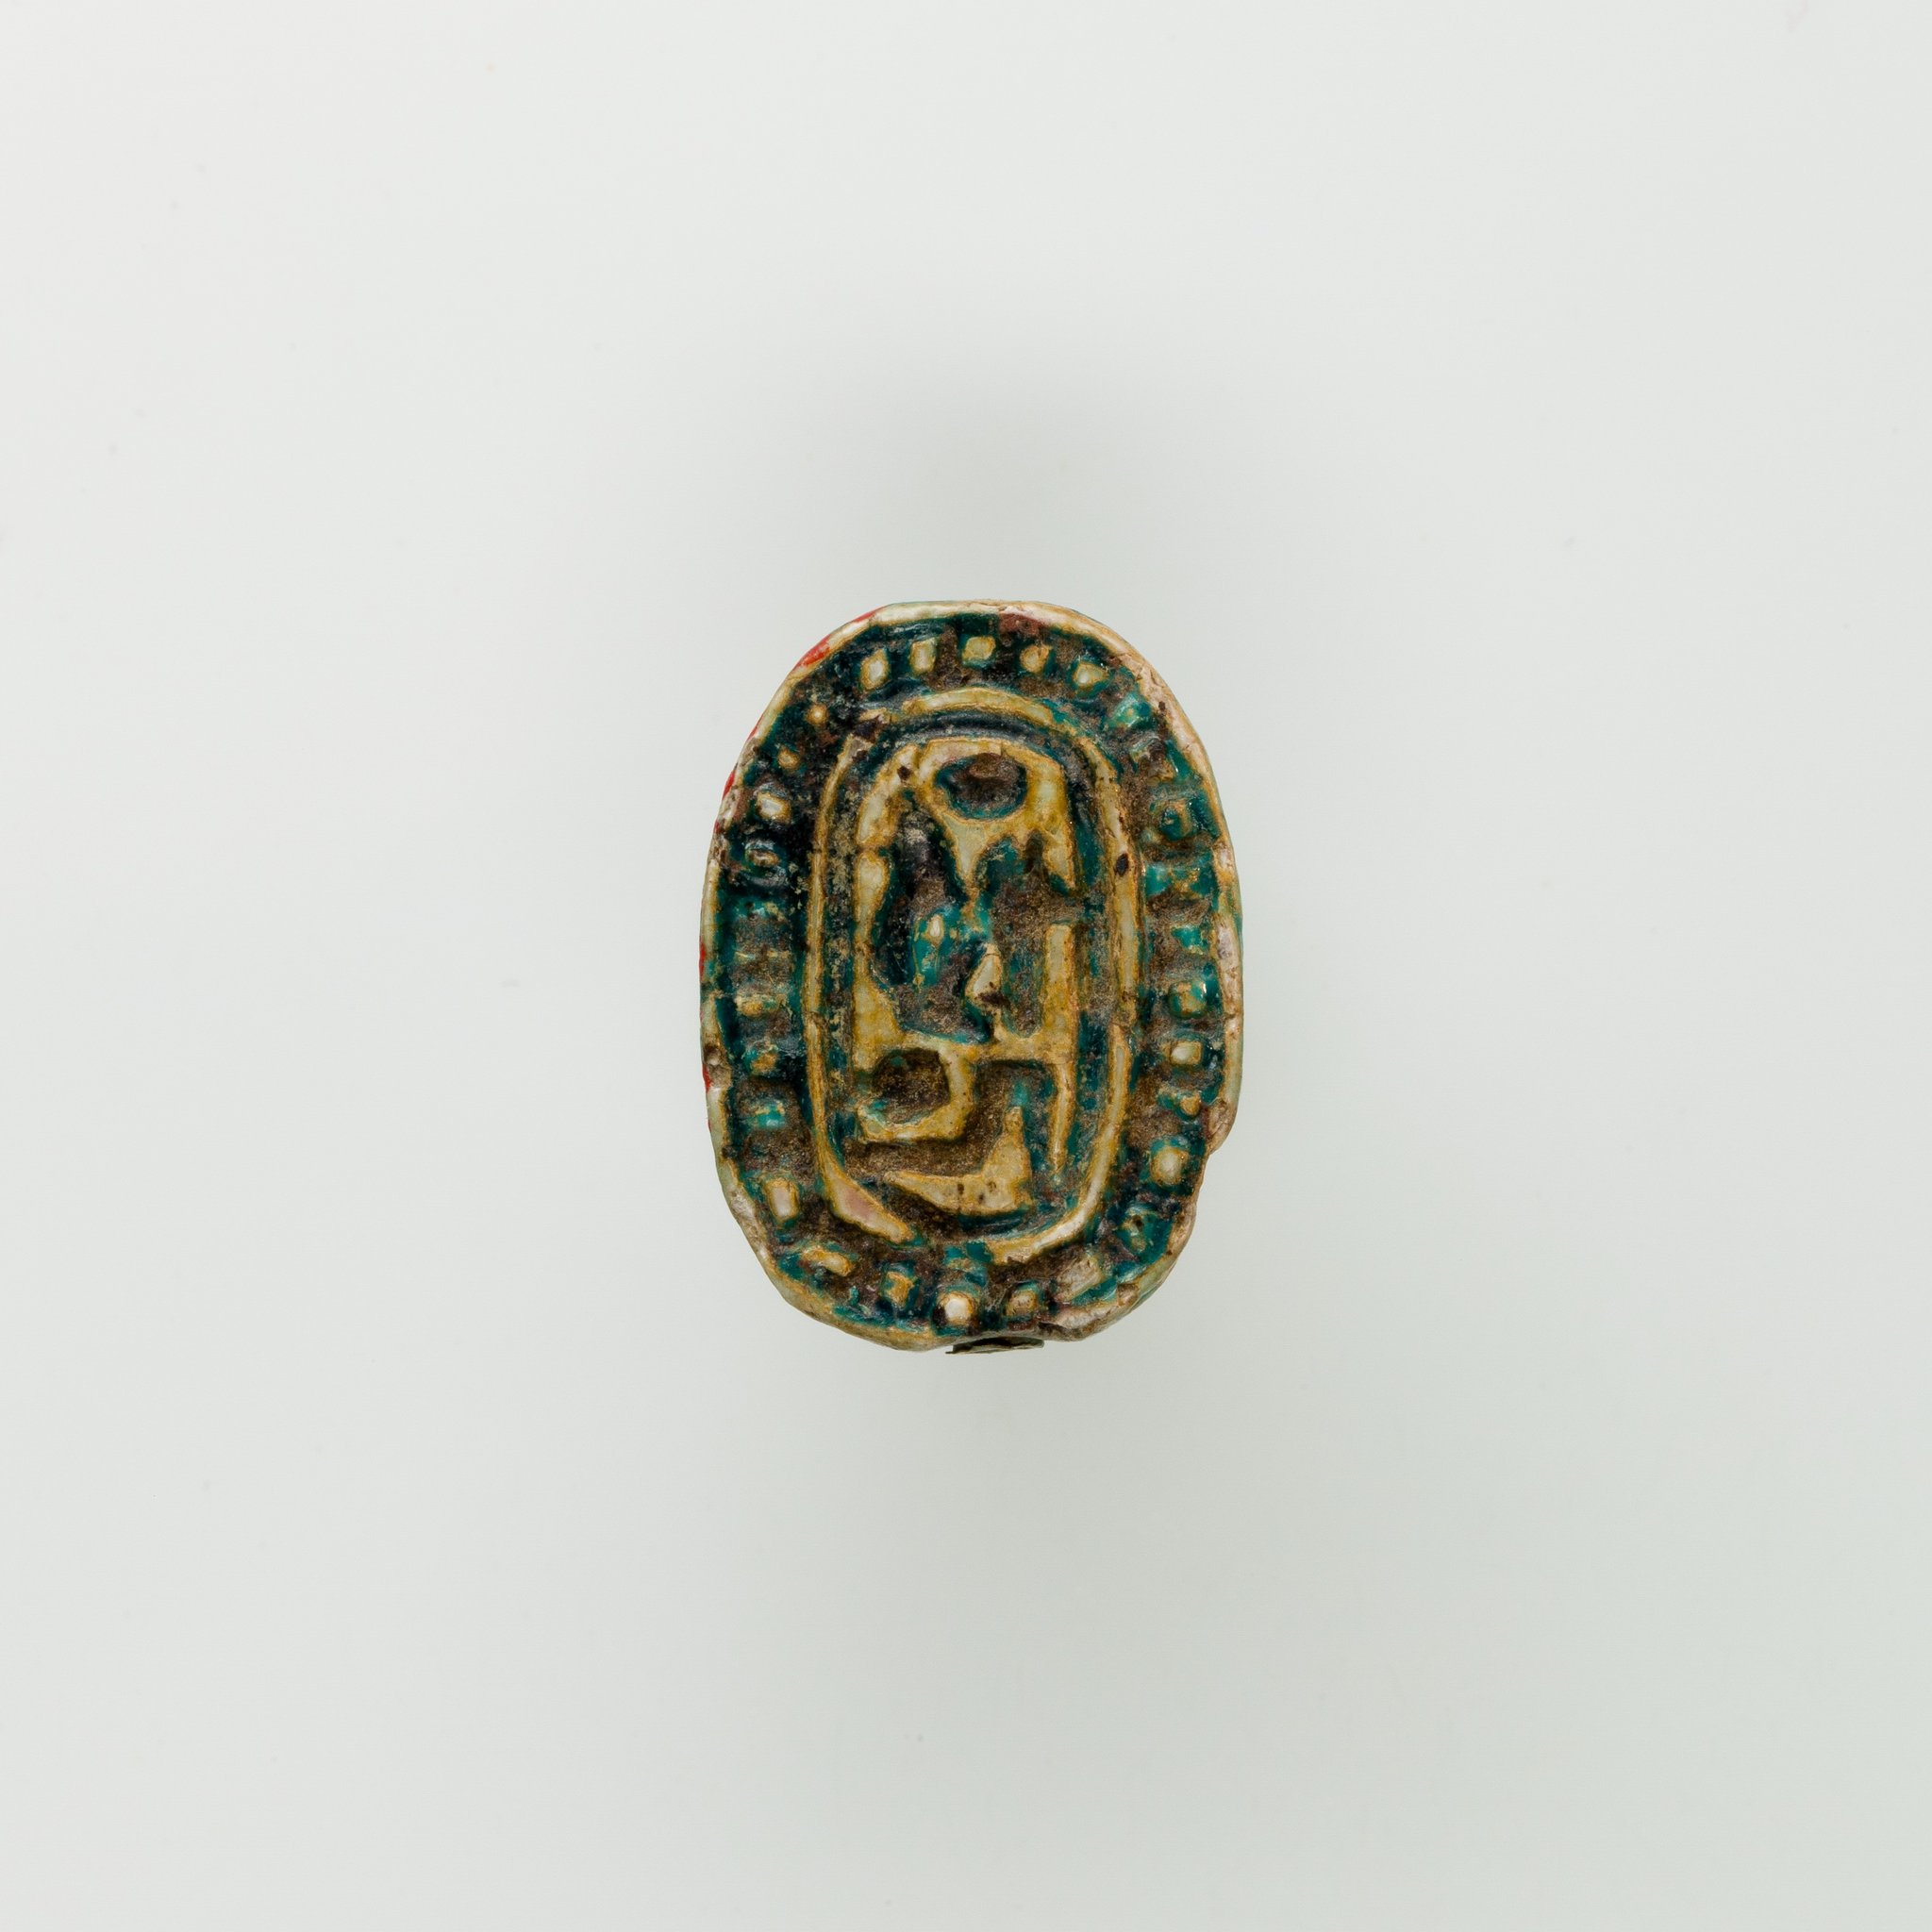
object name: scarab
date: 1295-1070 BCE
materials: stone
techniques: glazing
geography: egypt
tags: hieroglyphs,scarabs